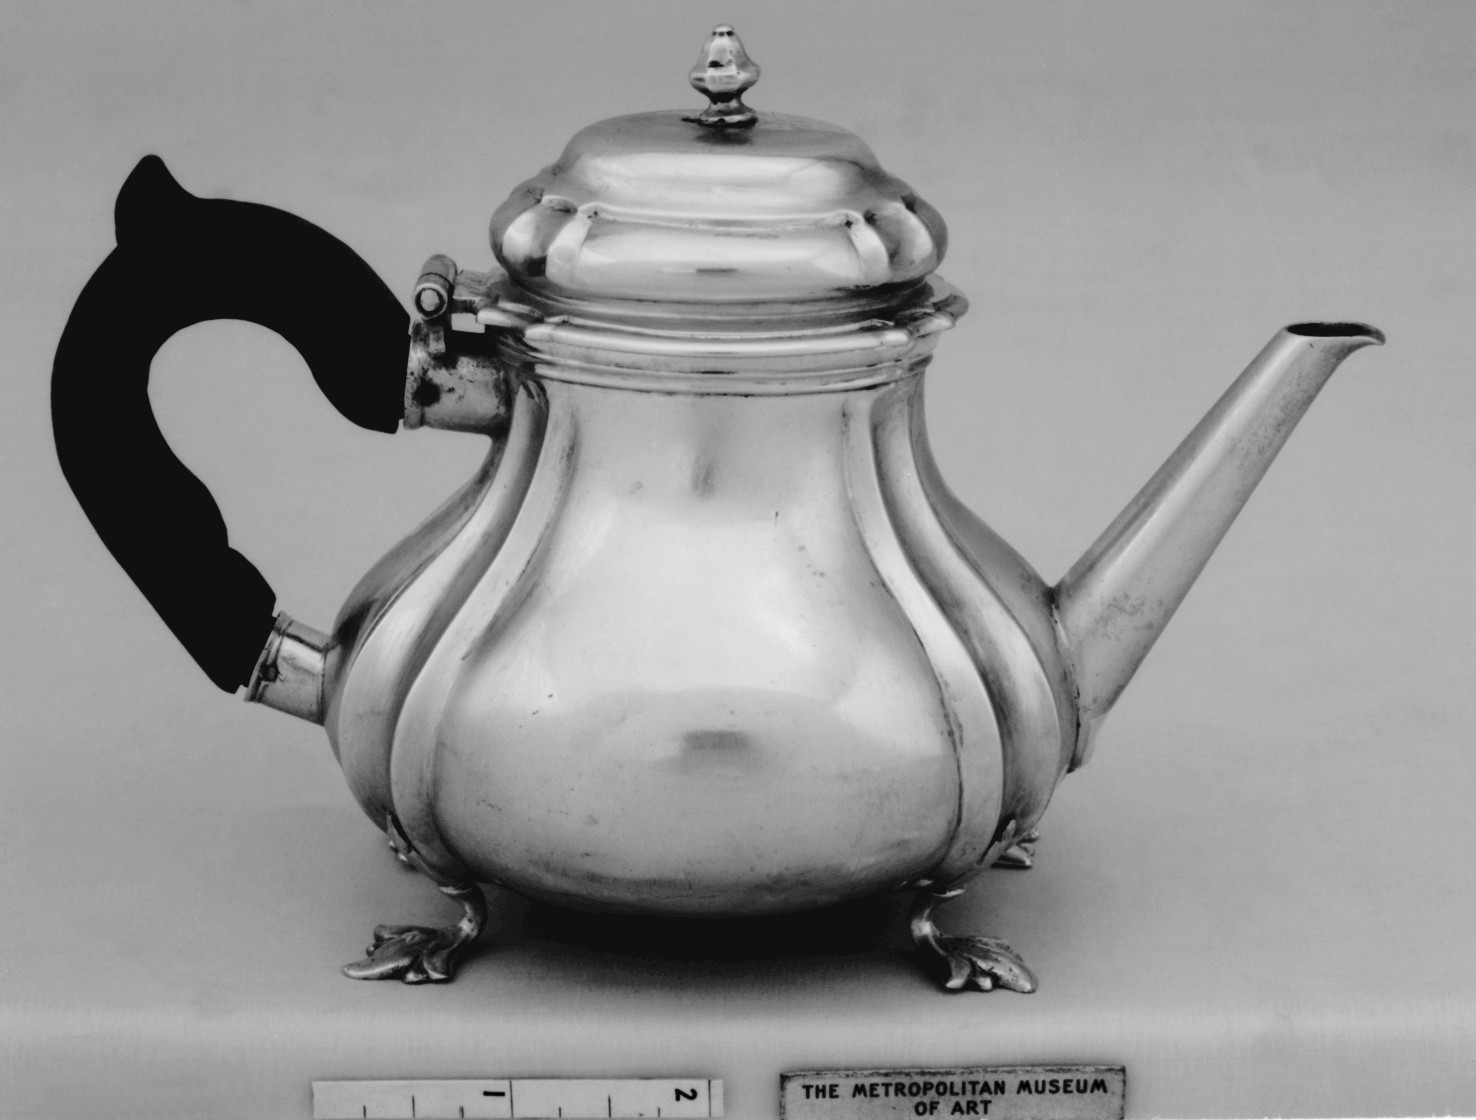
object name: teapot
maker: jacob von holten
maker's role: maker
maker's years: 1724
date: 1701-1800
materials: silver